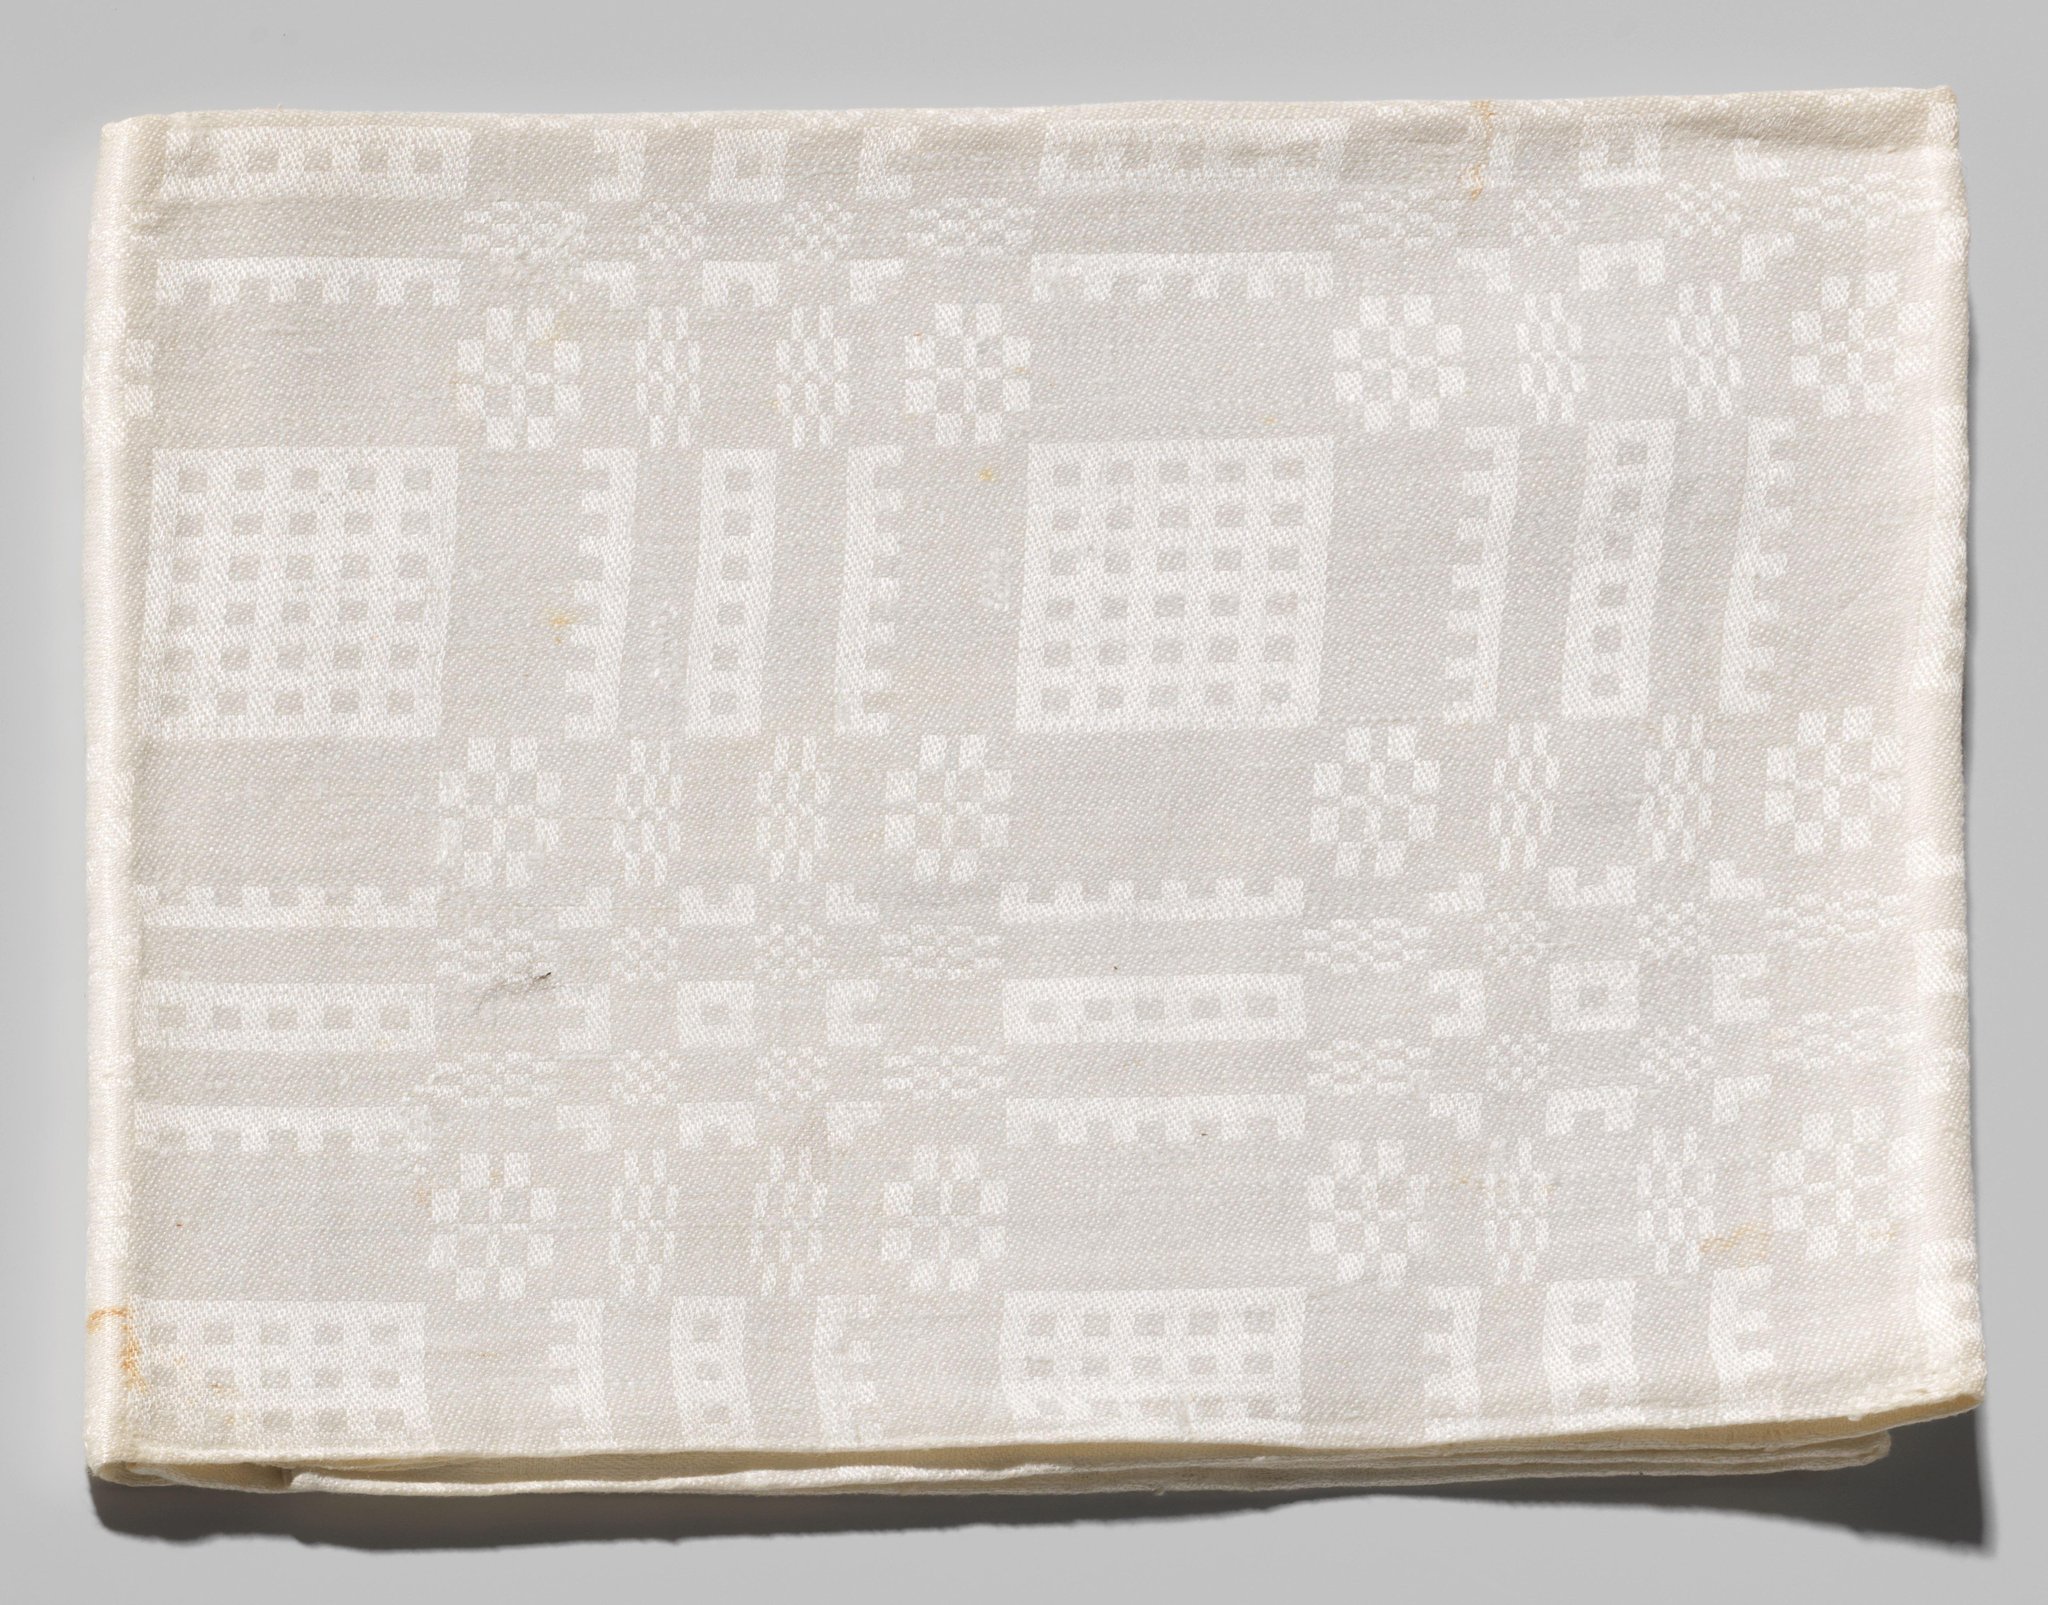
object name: dwaal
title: Servet of dwaal met pellenpatroon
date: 1790-1800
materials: linen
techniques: peeled fabric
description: Servet of dwaal van wit linnendamast met pellenpatroon: een oneindig rapport van geblokte vierkanten binnen een ruitpatroon, met op de knooppunten geblokte vierkanten en rechthoeken. Gemerkt in rode kruissteek KA 10 en in open platsteek A 12.